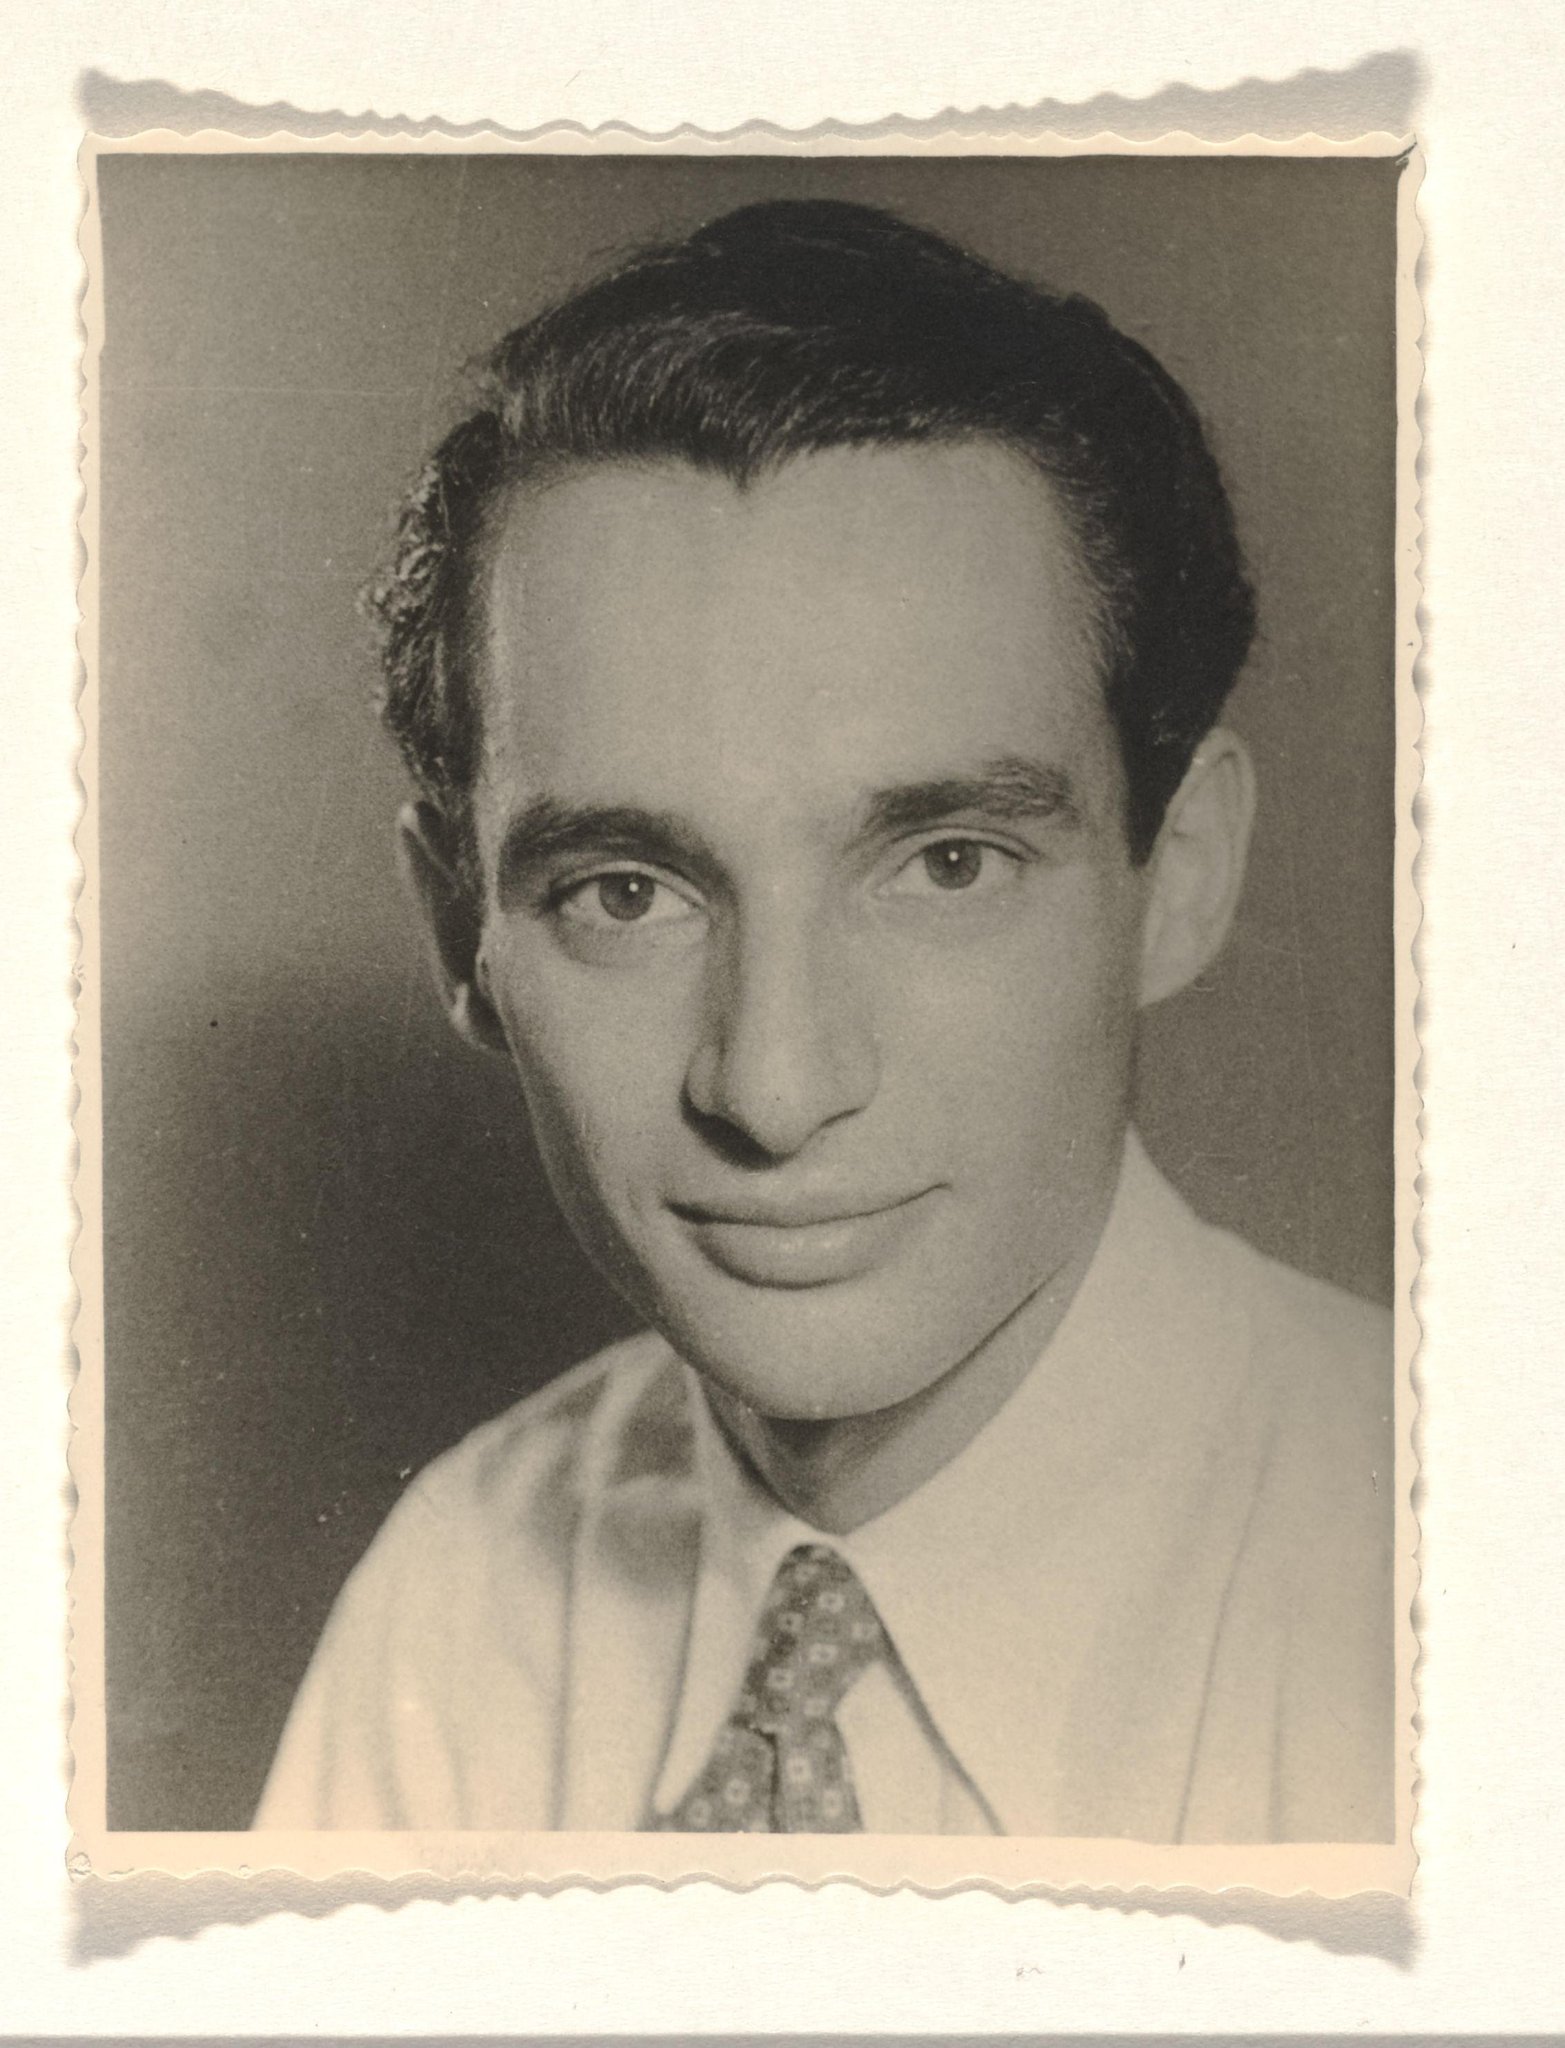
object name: photograph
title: Karl-Heinz Arndtheim, de tweede echtgenoot van Isabel Wachenheimer, in Israël tussen 1949 en 1955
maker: Anonymous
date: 1949-1955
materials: photographic support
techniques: gelatin silver print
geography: israel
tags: karl-heinz arndtheim, israël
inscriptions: number: ‘399’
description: Karl-Heinz Arndtheim, de tweede echtgenoot van Isabel Wachenheimer.